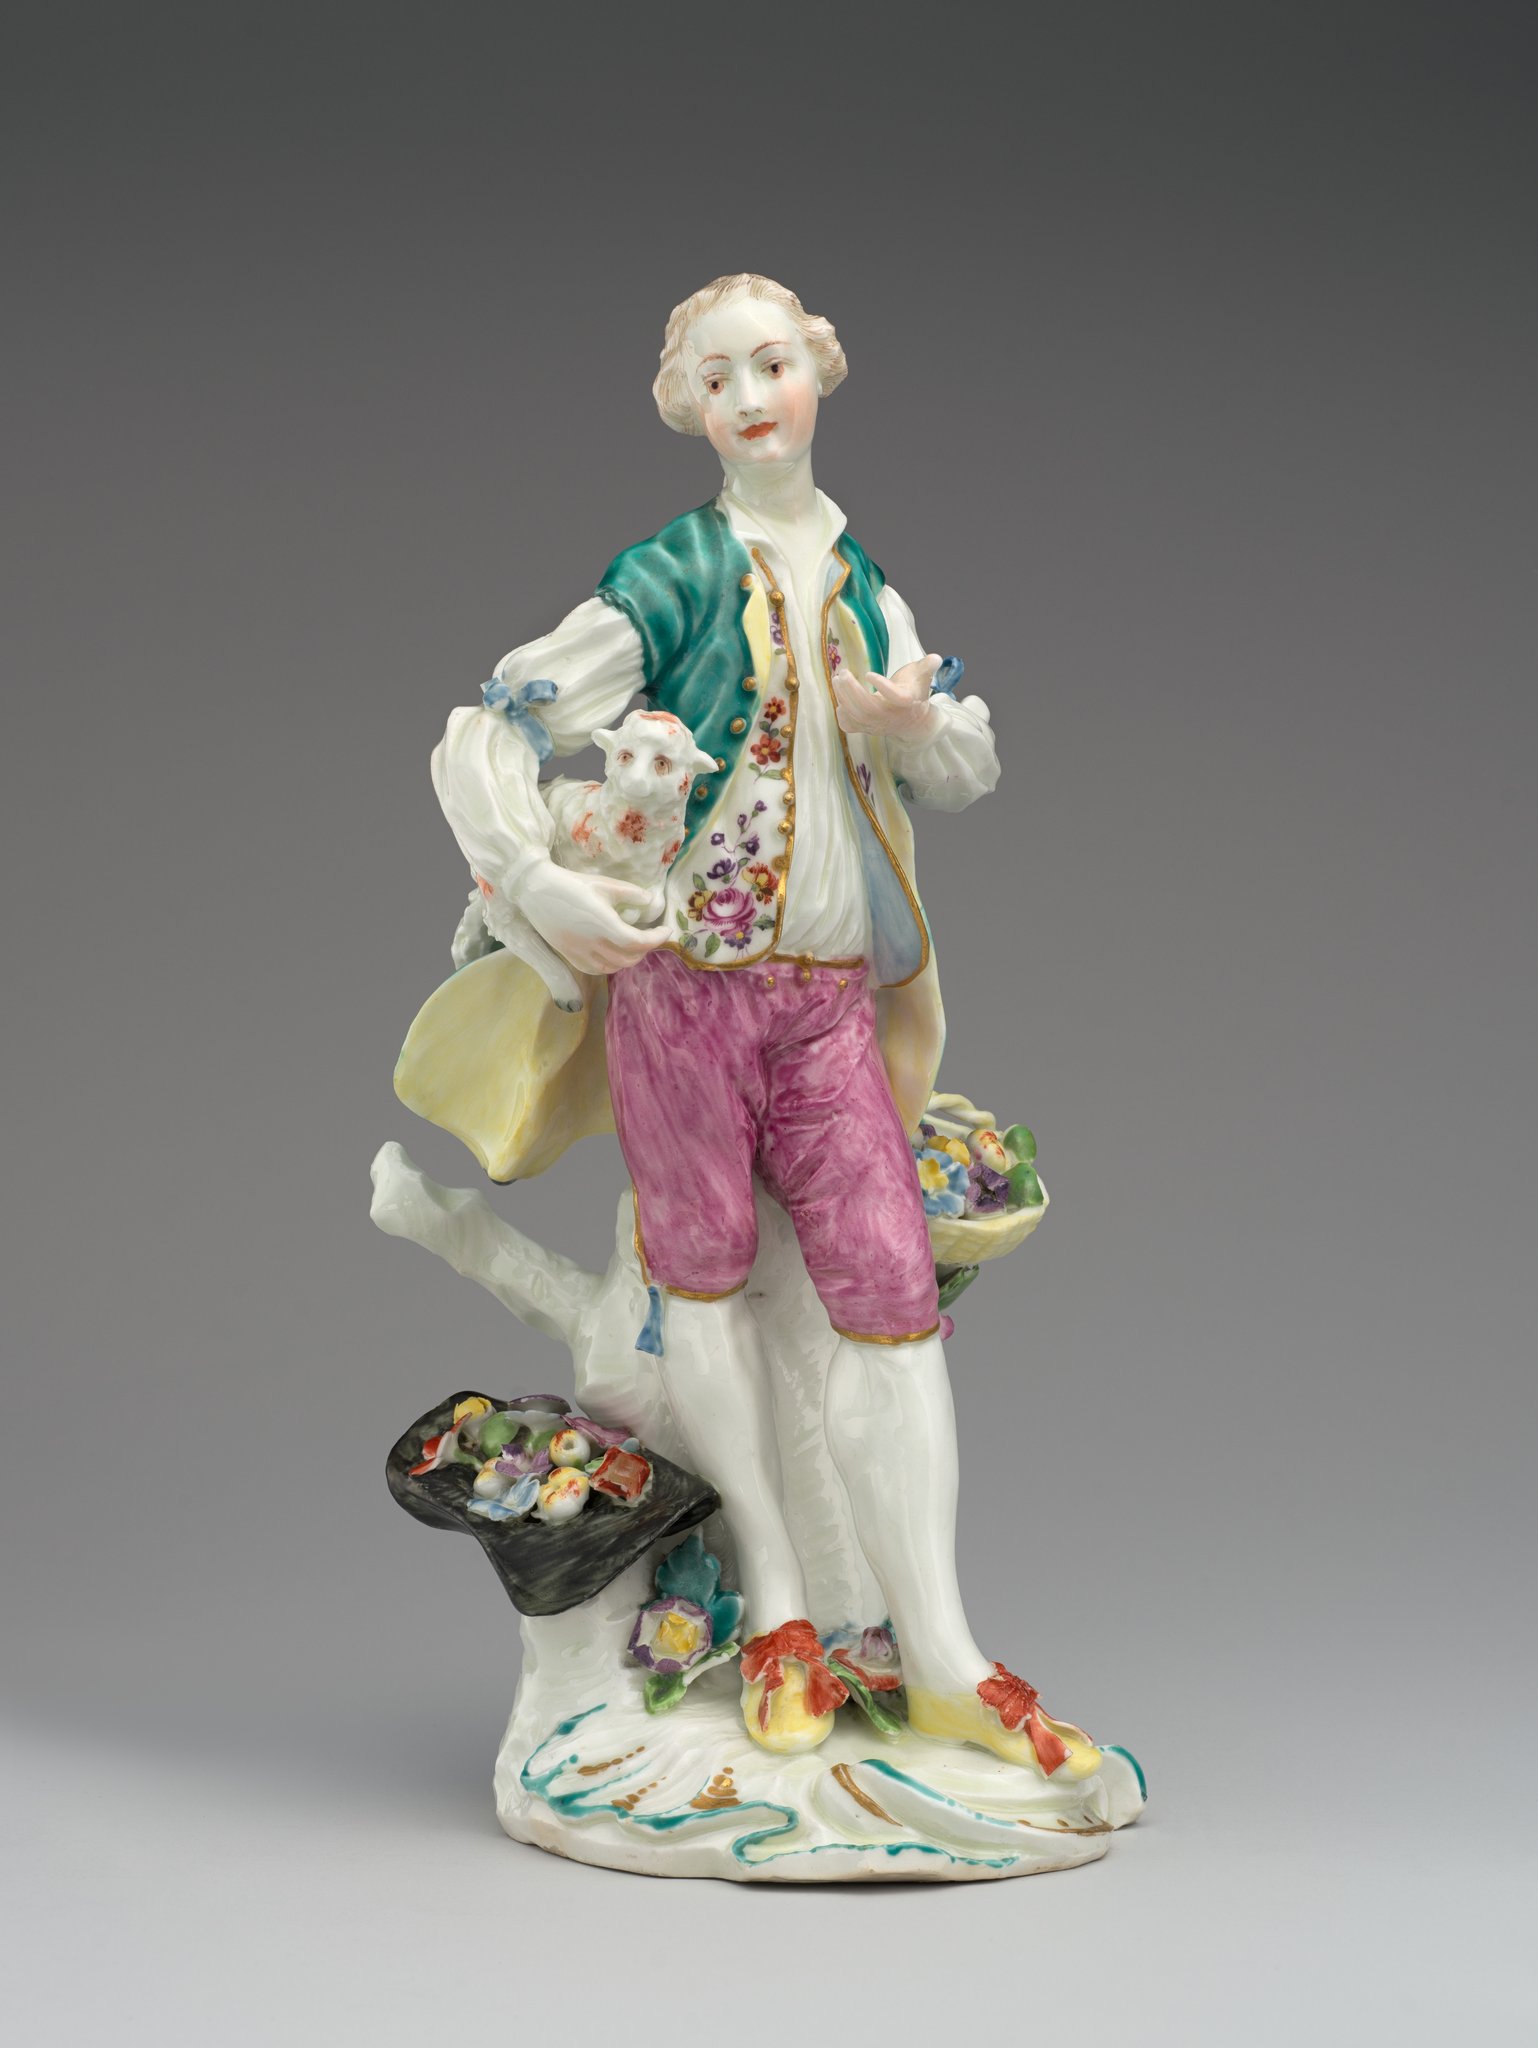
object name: figure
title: Shepherd (one of a pair)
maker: derby porcelain manufactory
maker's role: factory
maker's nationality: british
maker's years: 1751-1785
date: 1760-1765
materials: soft paste porcelain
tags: sheep,shepherds